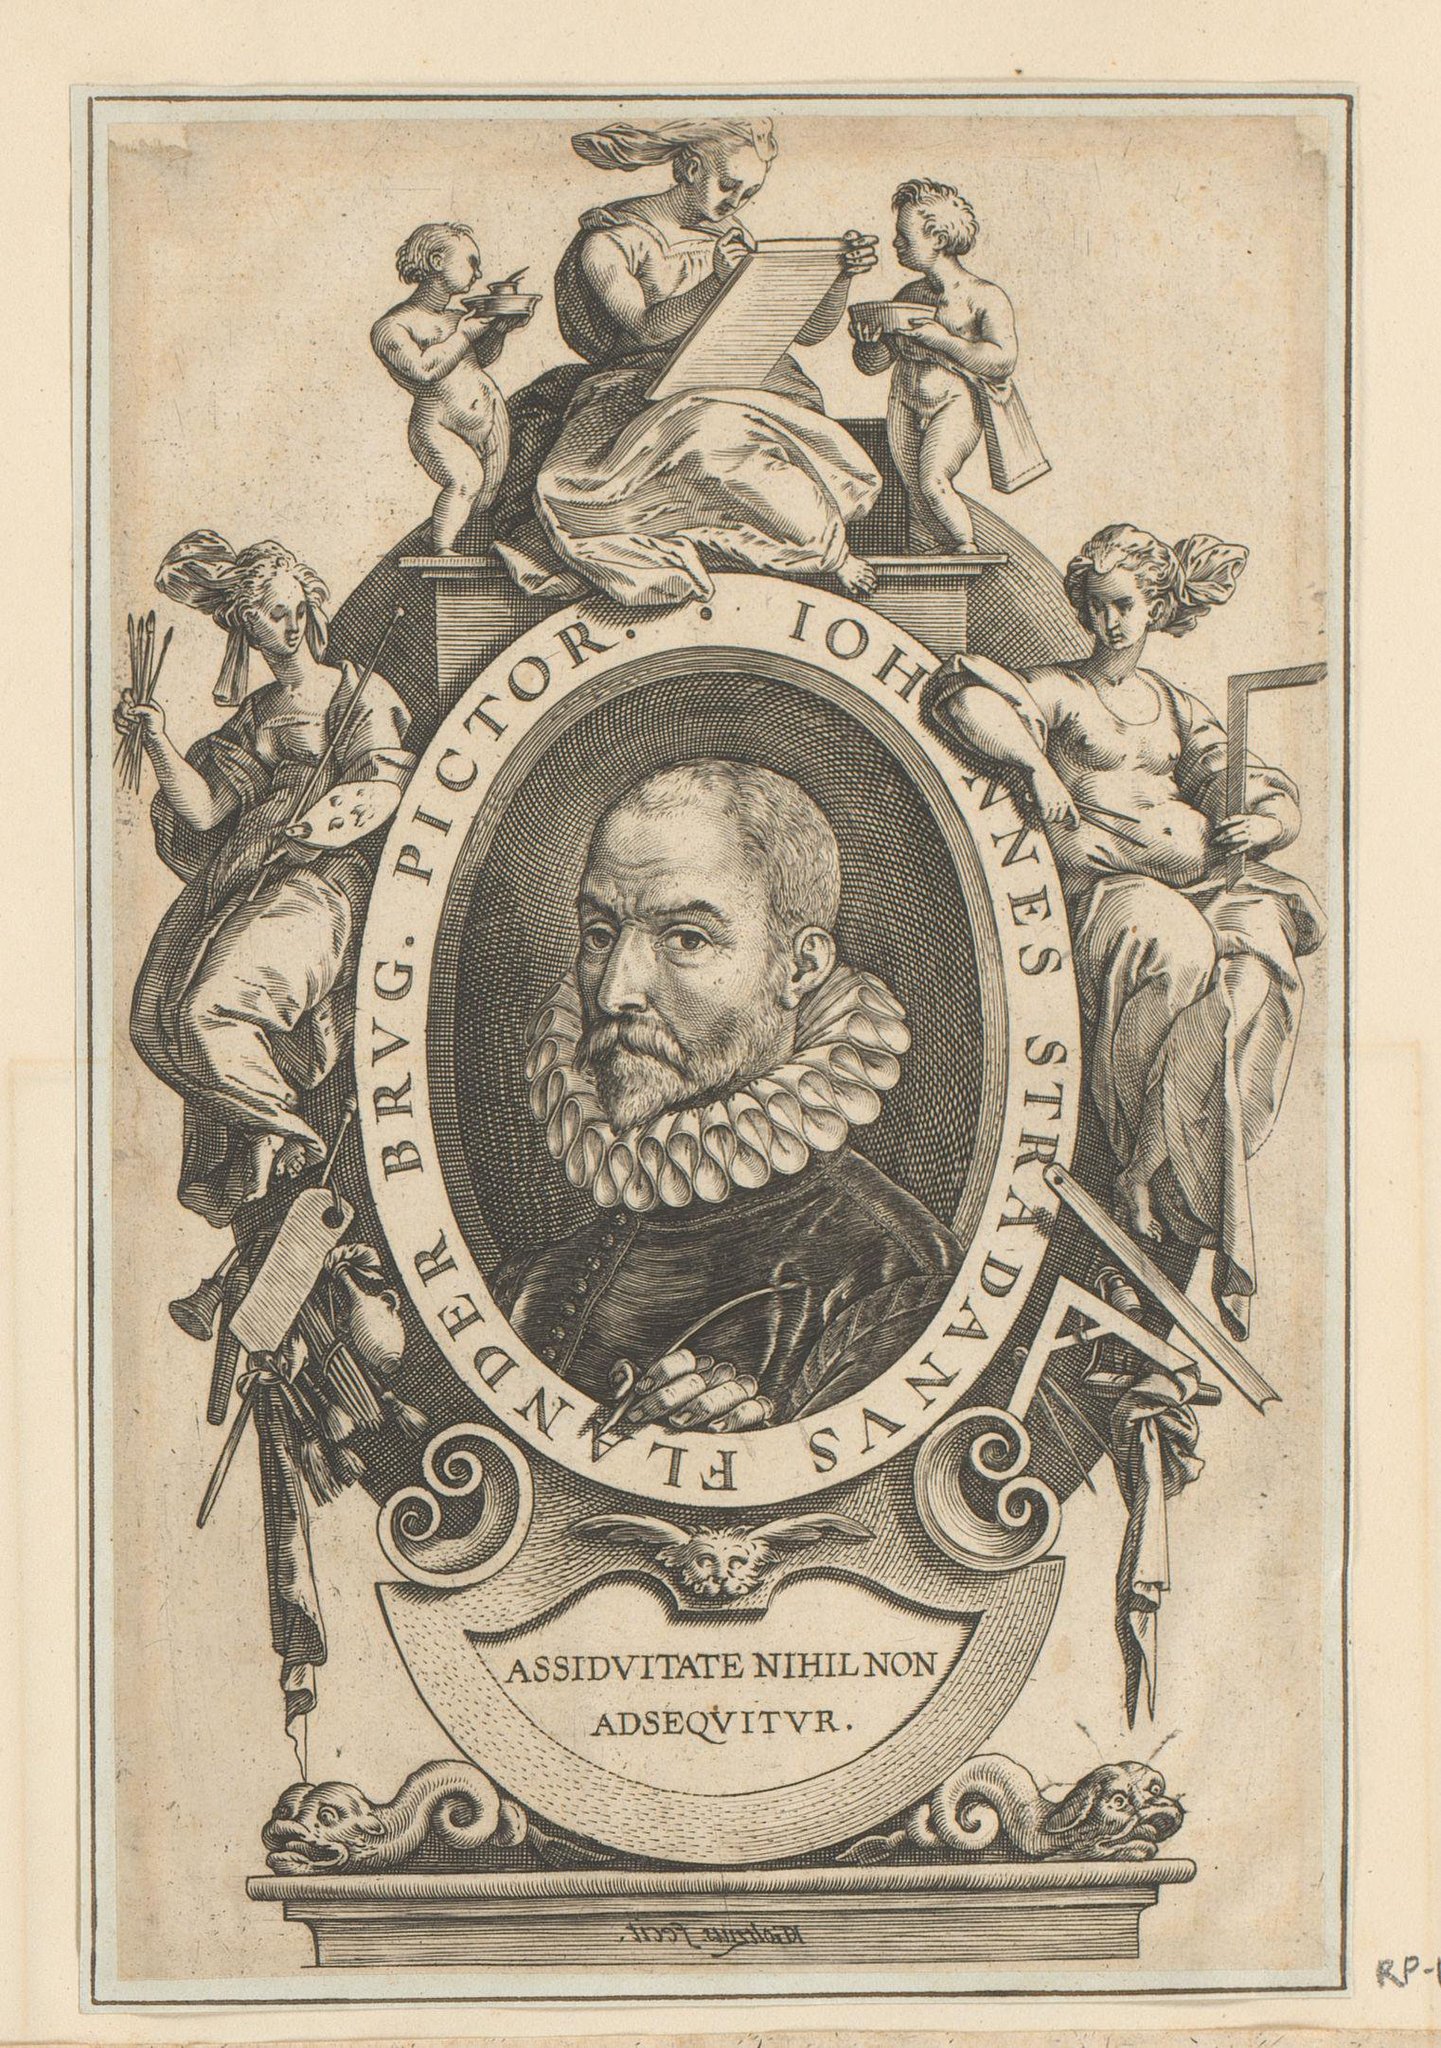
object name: album leaf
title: Portret van Jan van der Straet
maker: hendrick goltzius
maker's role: draughtsman, painter, print maker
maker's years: 1558-1617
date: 1581-1583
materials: paper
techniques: engraving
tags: bruges, draughtsman, jan van der straet, 'pictura', symbolic representations, allegories and emblems ~ painting; 'pittura' (ripa), neck-gear ~ clothing (with name) (+ men's clothes), historical persons, portrait, self-portrait of painter, portrait, self-portrait of artist, 'architectura', symbolic representations, allegories and emblems ~ architecture; 'architettura' (ripa), symbolic representations, allegories and emblems ~ drawing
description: Portret van Jan van der Straet (ook bekend onder zijn gelatiniseerde naam Johannes Stradanus). In de omlijsting zijn de personificaties van de Schilderkunst, Tekenkunst en Architectuur met hun diverse attributen verwerkt. Prent maakt deel uit van een album.